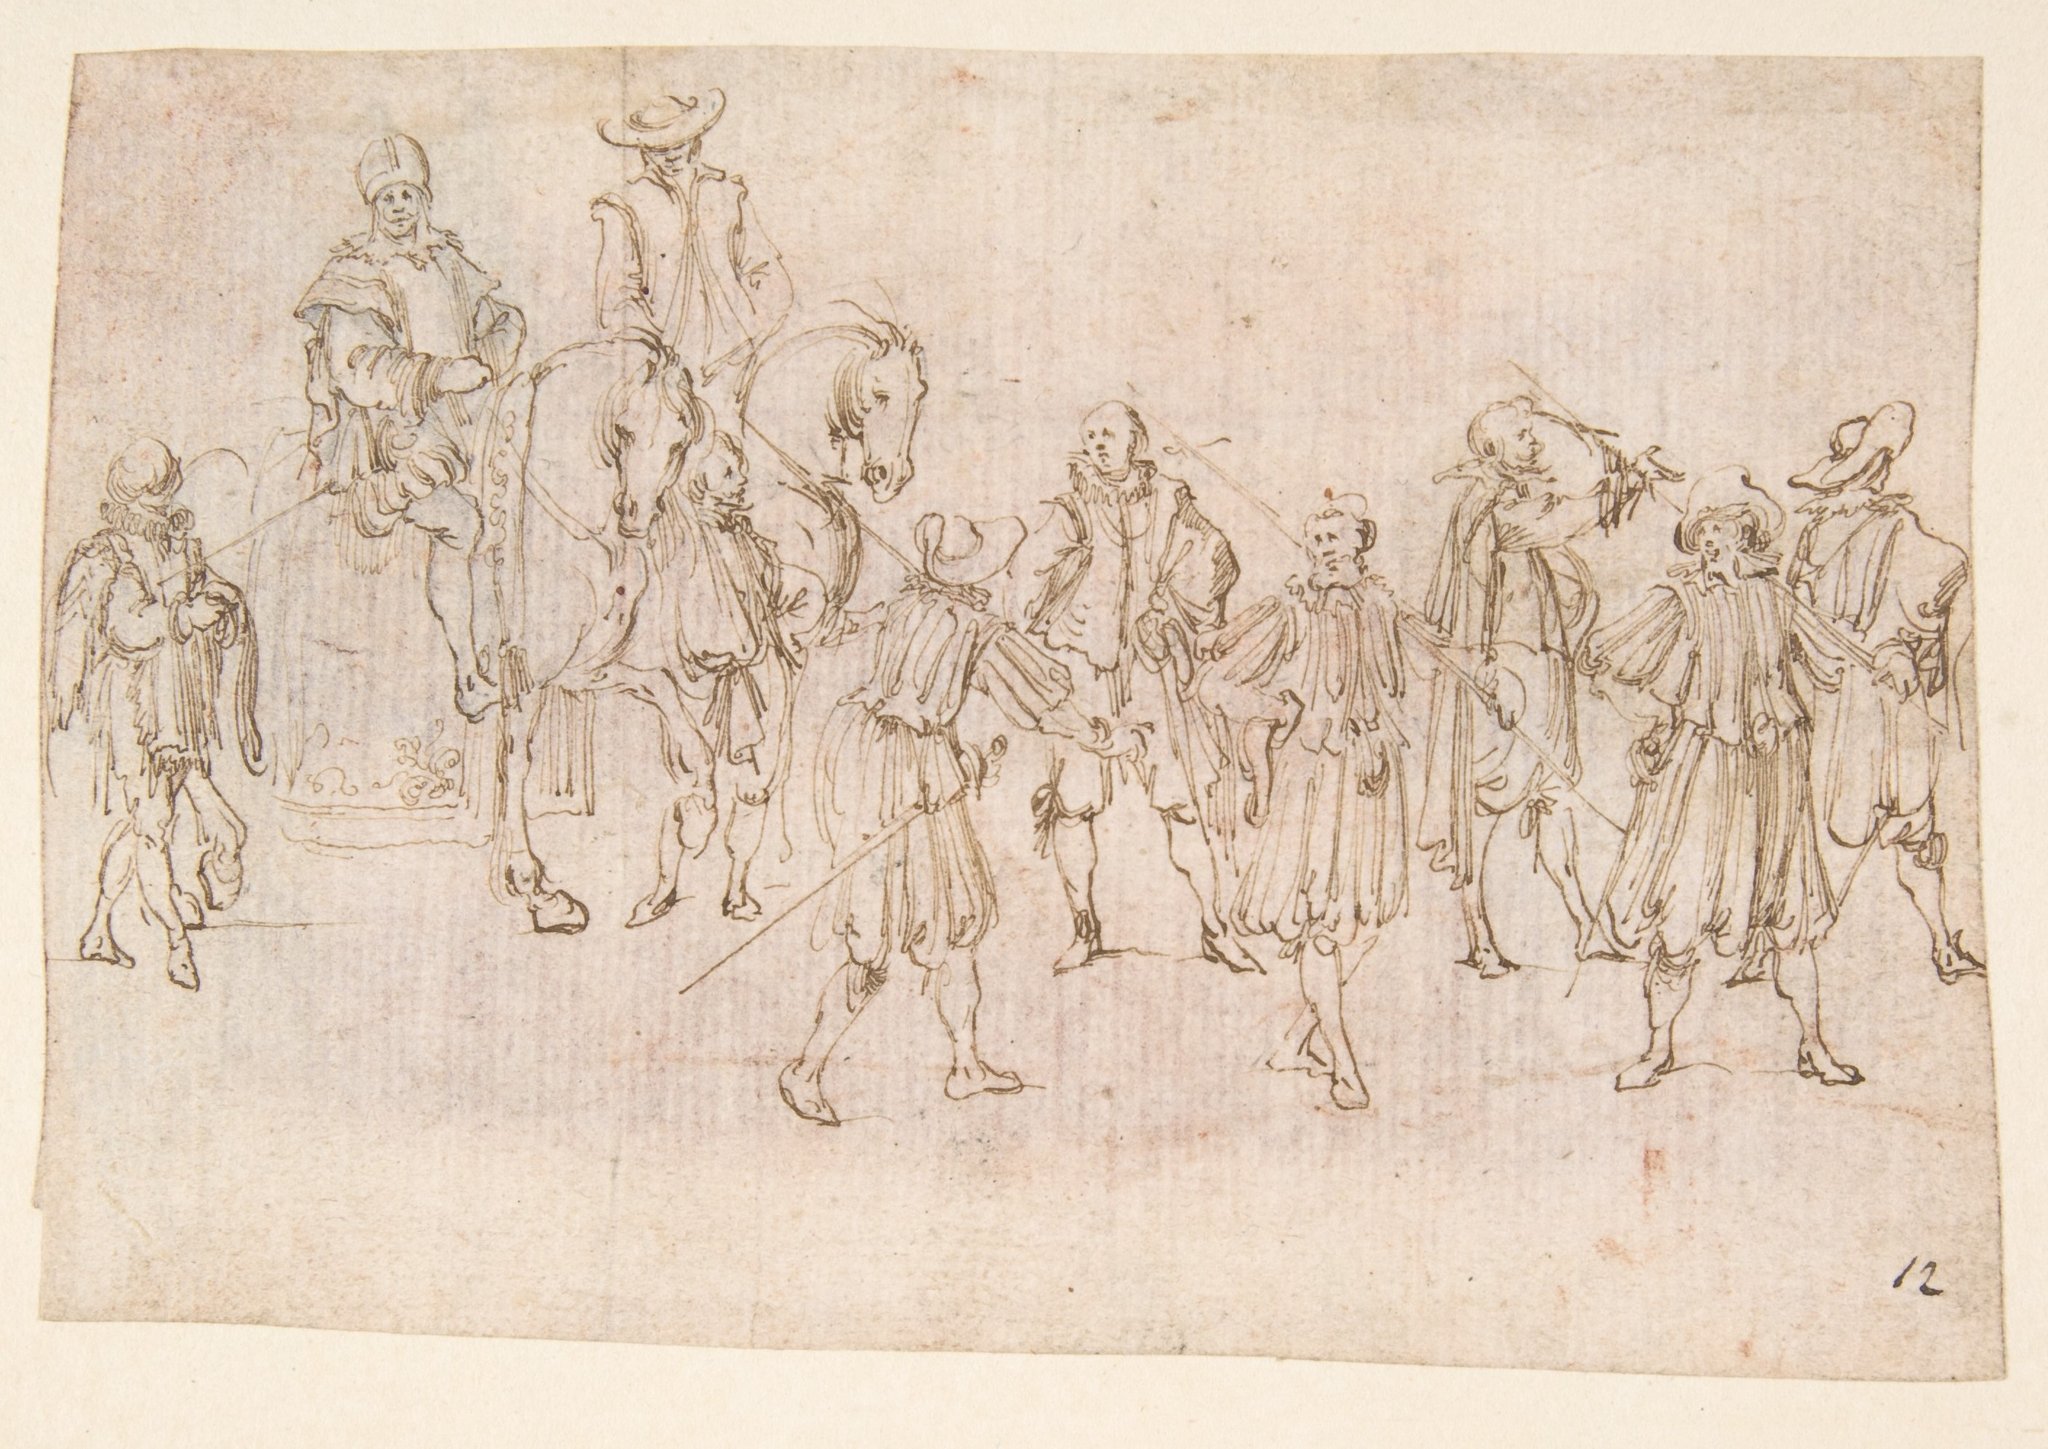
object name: drawing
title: Horsemen and Soldiers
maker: stefano della bella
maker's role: artist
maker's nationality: italian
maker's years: 1610-1664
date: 1610-1664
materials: ink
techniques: pen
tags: soldiers,men,horses